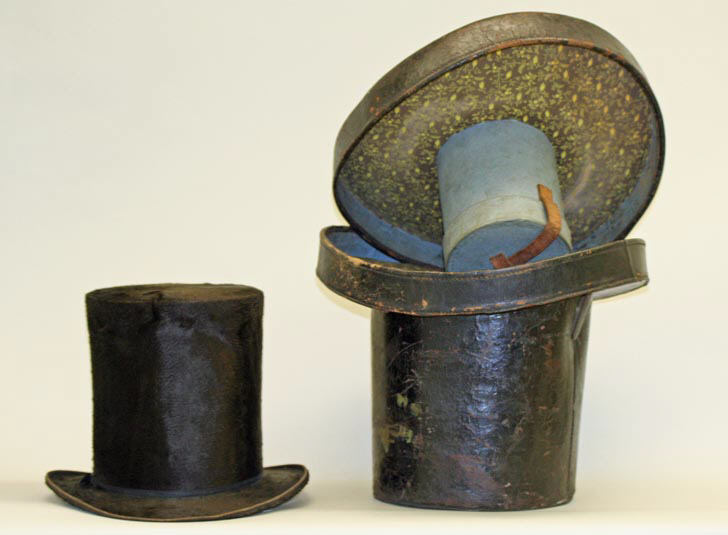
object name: hat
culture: american or european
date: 1829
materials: fur, leather, metal, silk